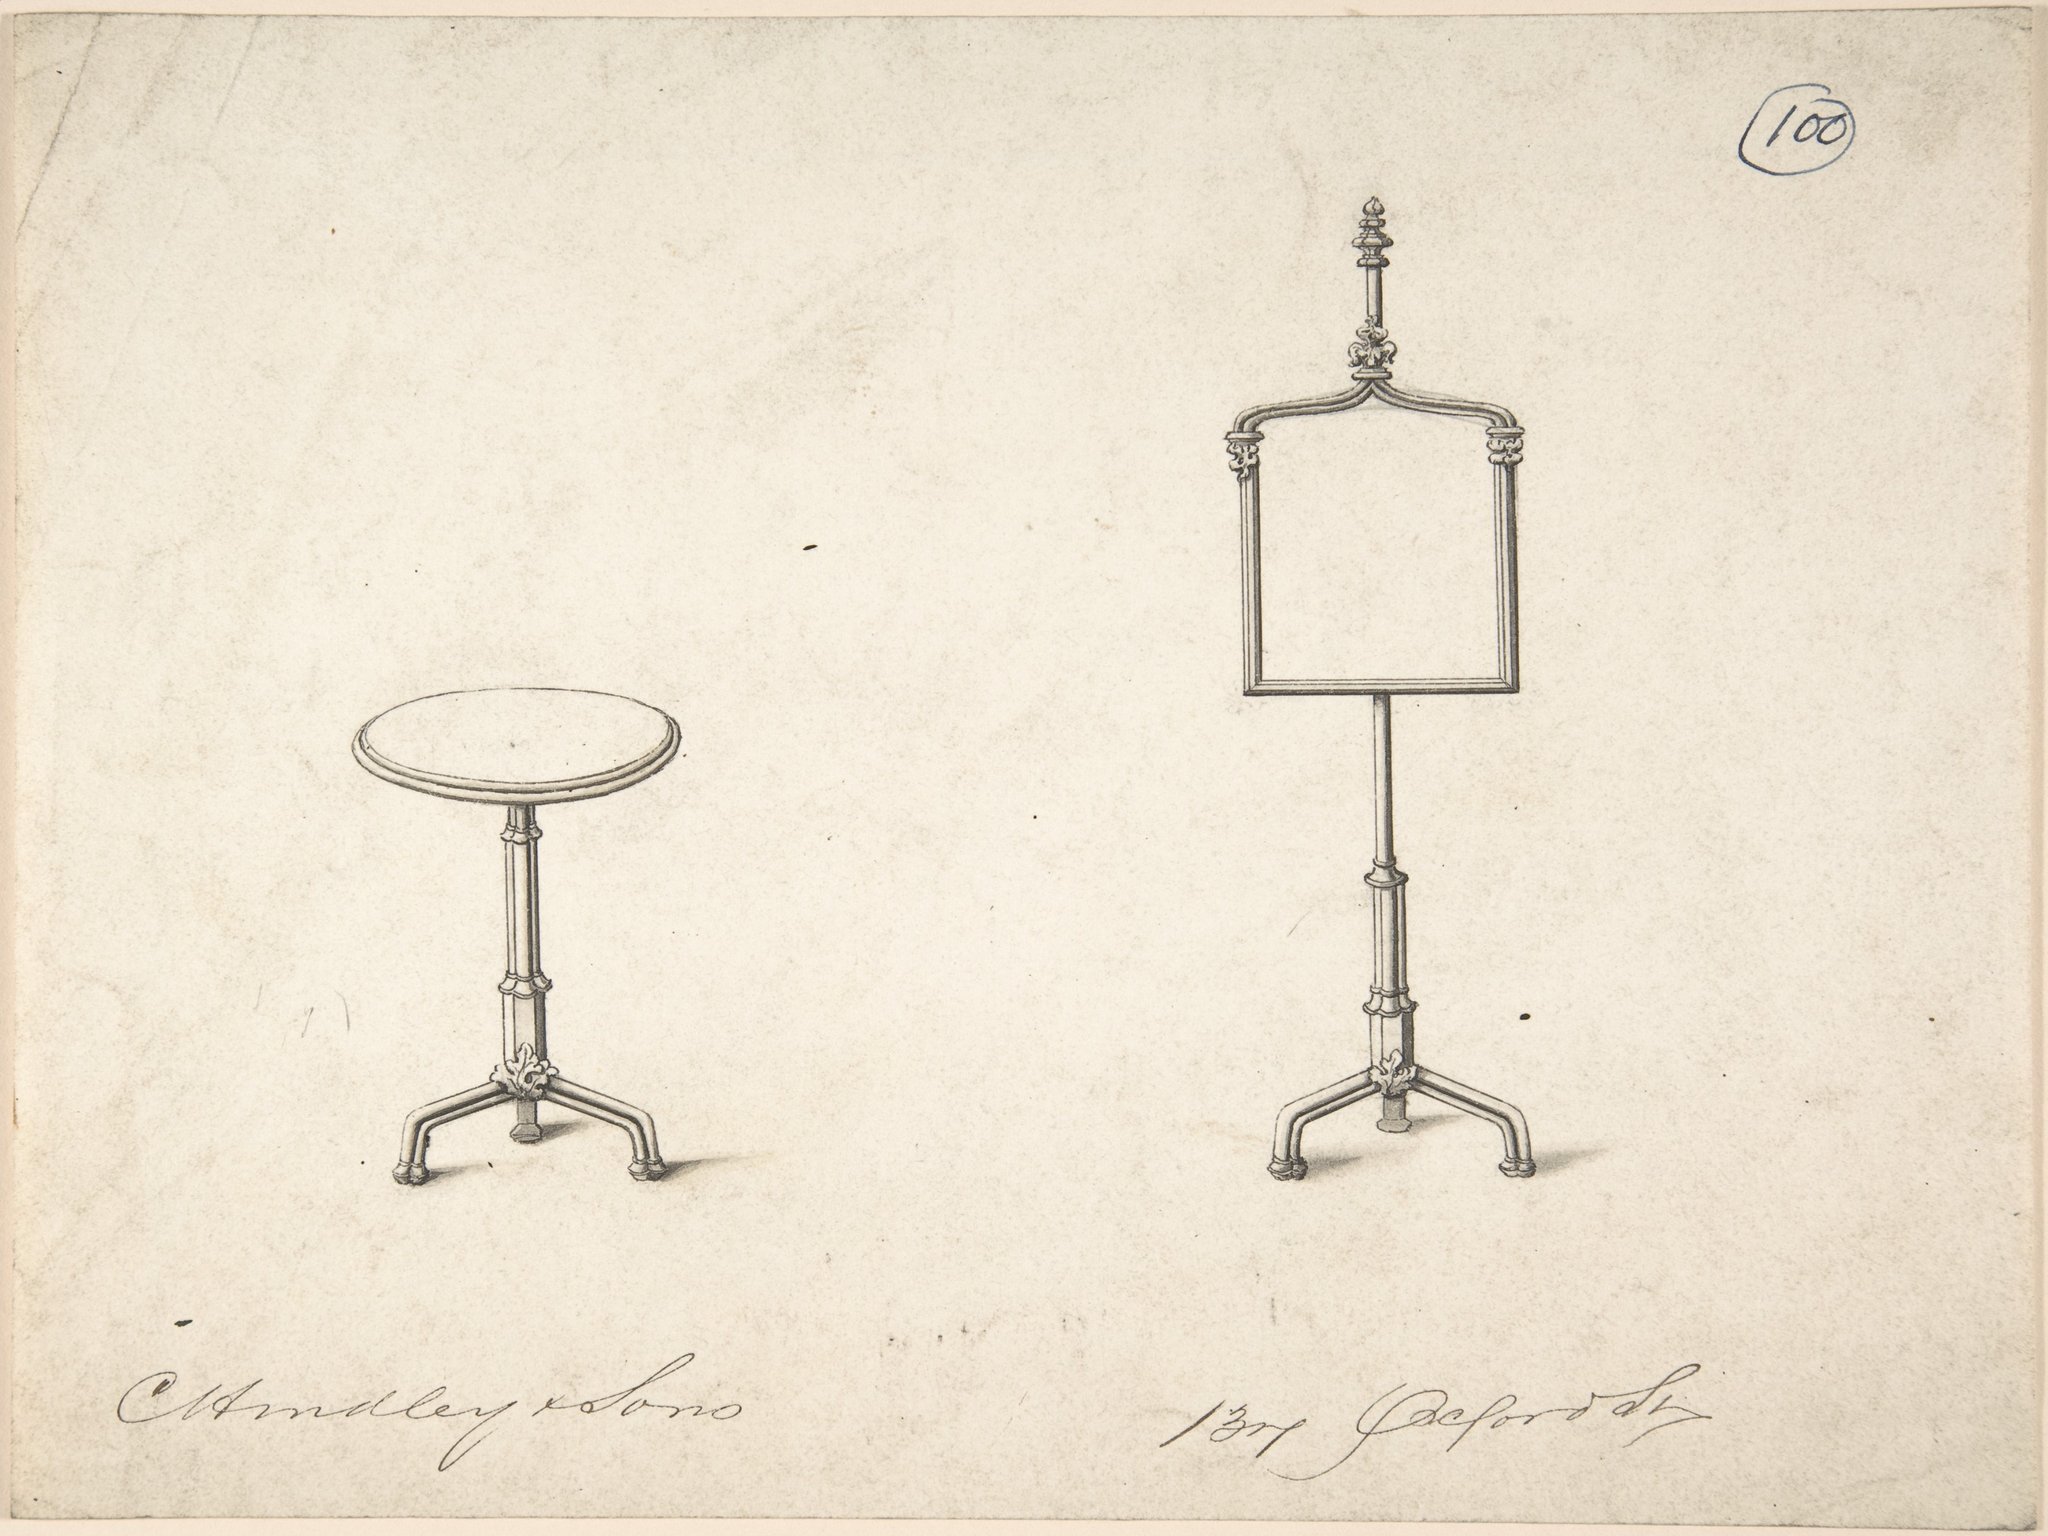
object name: drawing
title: Design for a Standing Frame and End Table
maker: charles hindley and sons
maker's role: artist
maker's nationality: british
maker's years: 1841-1917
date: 1841-1884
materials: ink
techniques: brush, pen, wash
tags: tables